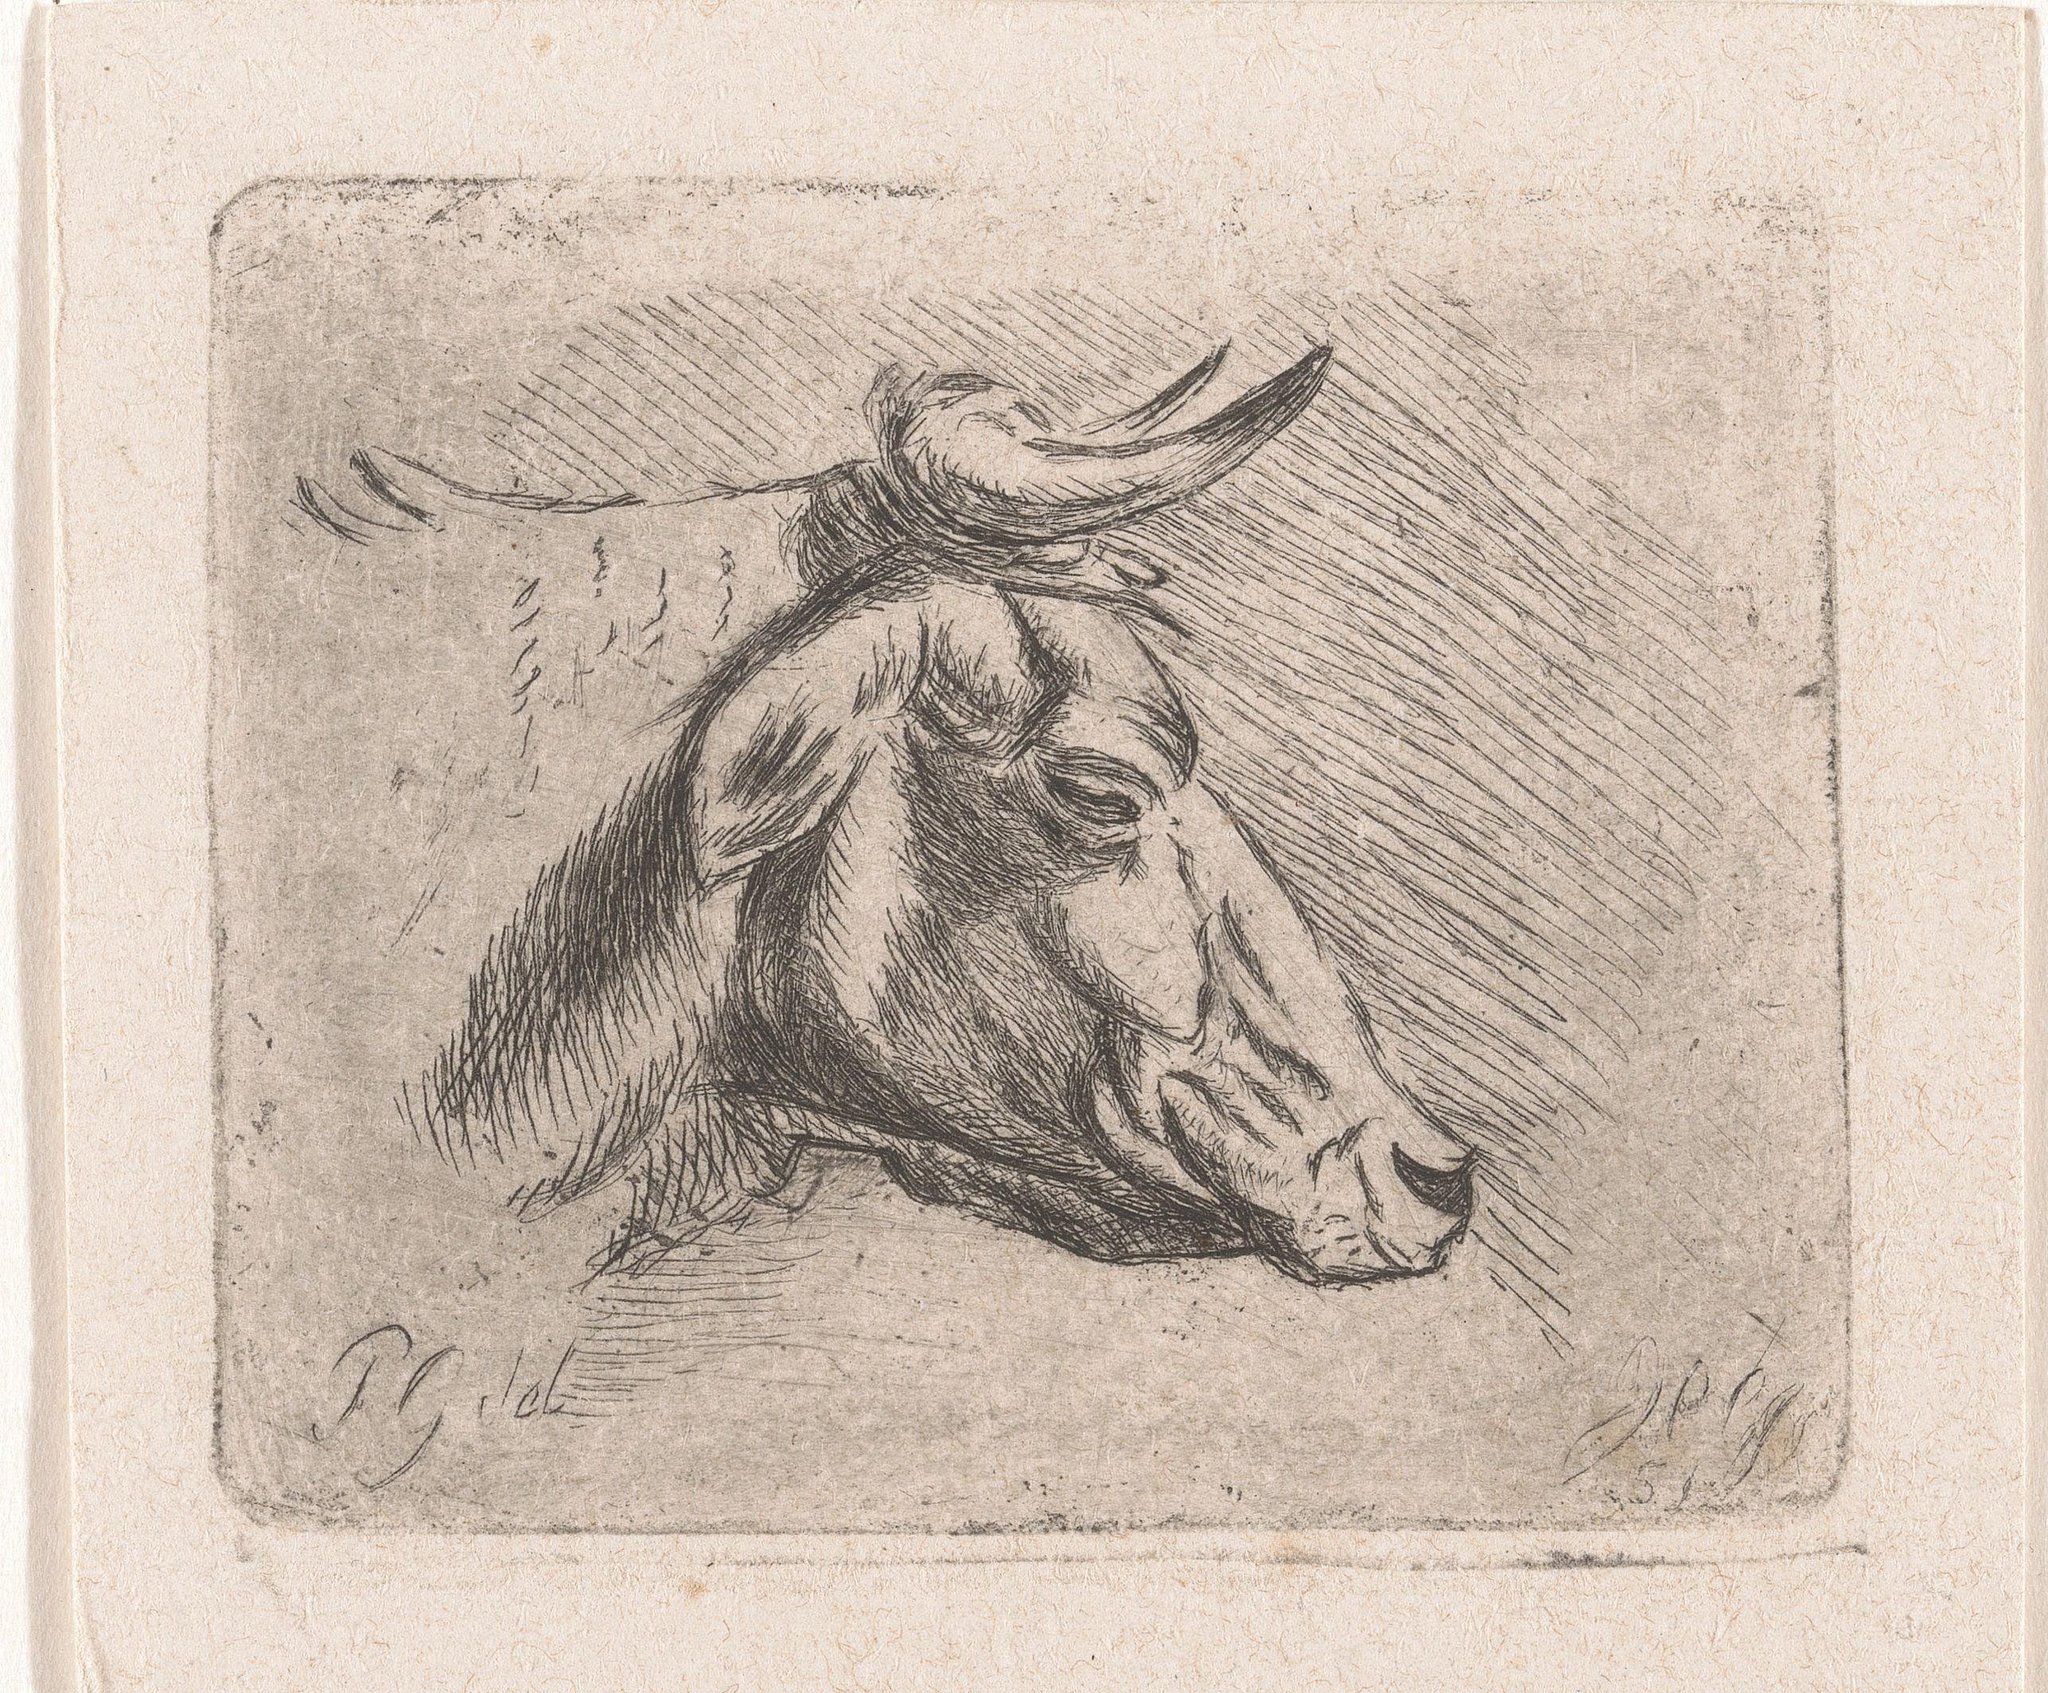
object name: print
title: Kop van een stier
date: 1851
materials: paper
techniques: etching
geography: netherlands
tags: calf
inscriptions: collector's mark: Lugt 2228